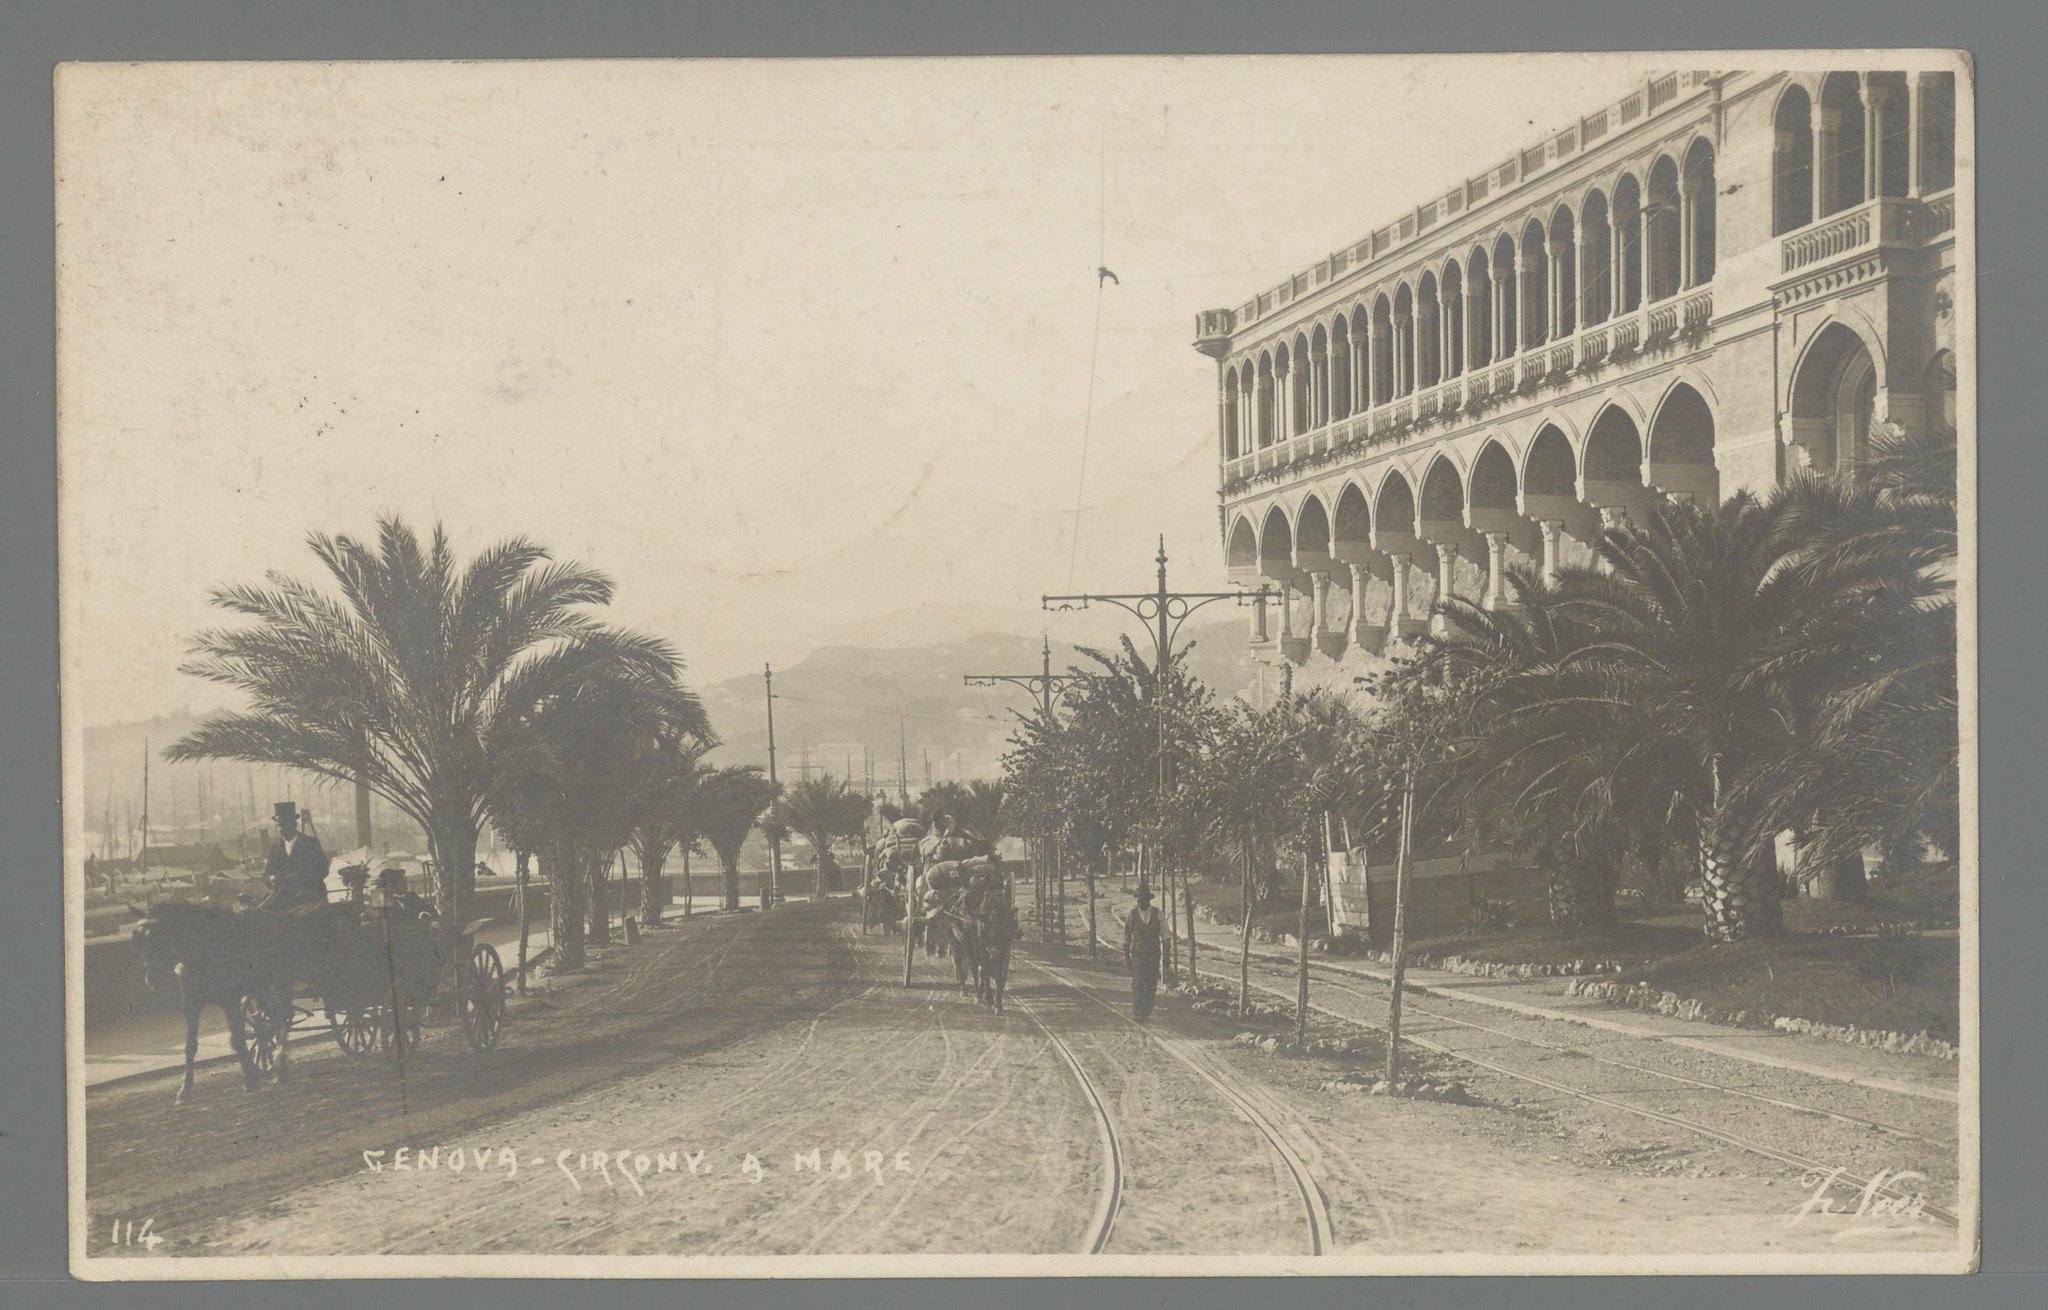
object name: photograph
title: Genova. Circonv. a Mare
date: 1906-1908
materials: paper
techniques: gelatin silver print, writing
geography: genoa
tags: tram, trees: palm-tree, street (+ city(-scape) with figures, staffage)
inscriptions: postage stamp